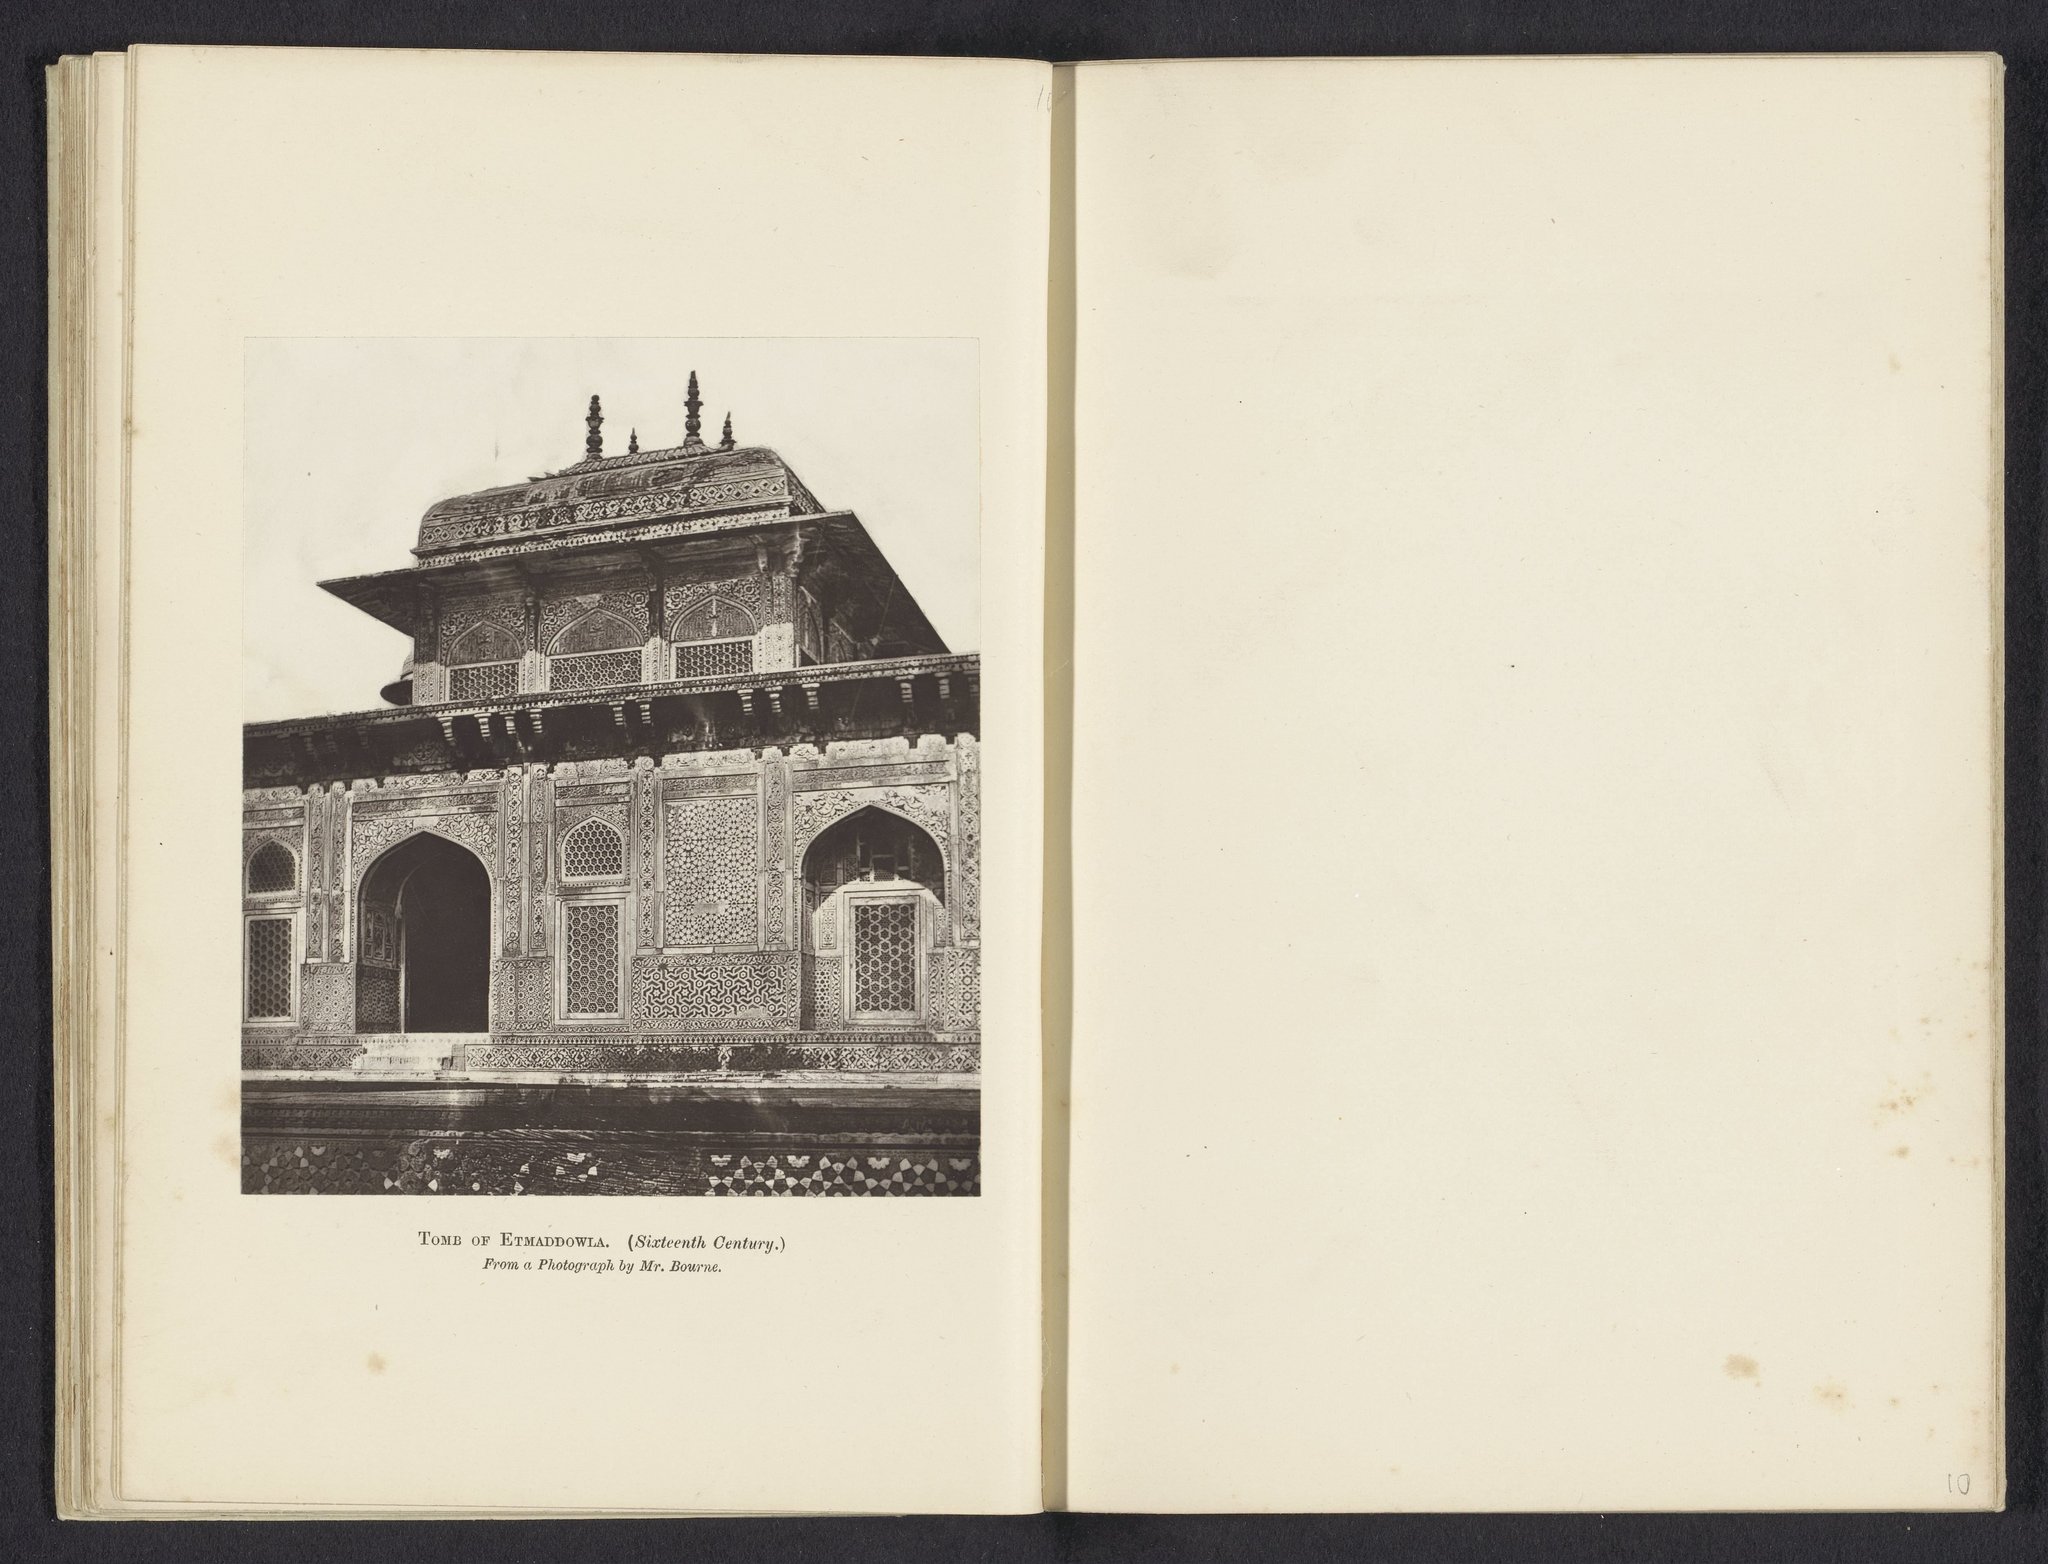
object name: page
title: Exterior of the Tomb of Itimad-ud-Daulah at Agra, Uttar Pradesh, India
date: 1864-1869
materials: paper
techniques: woodburytype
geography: agra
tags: mausoleum, façade (of house or building)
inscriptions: caption: ‘TOMB OF ETMADDOWLA. (Sixteenth Century.)/ From a Photograph by Mr. Bourne.’